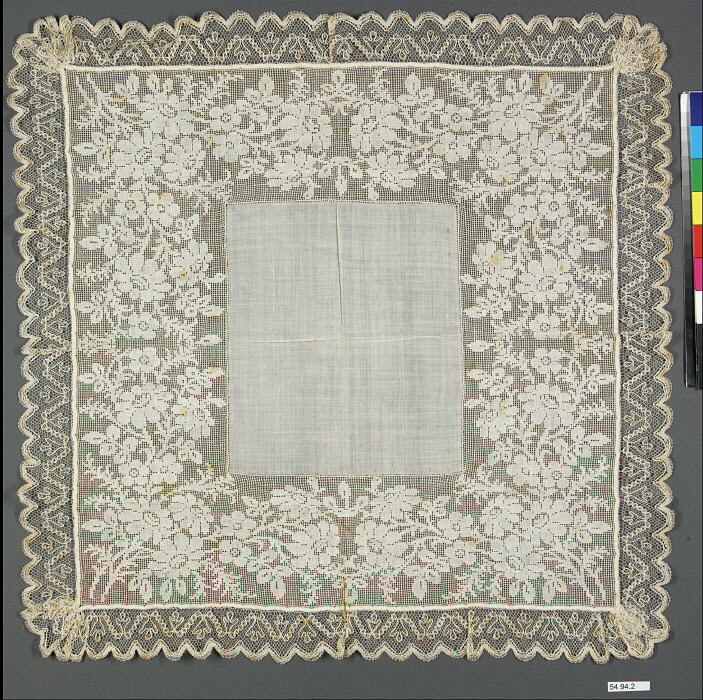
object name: handkerchief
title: Handkerchiefs (one of two)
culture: brazilian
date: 1850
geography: brazil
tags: flowers